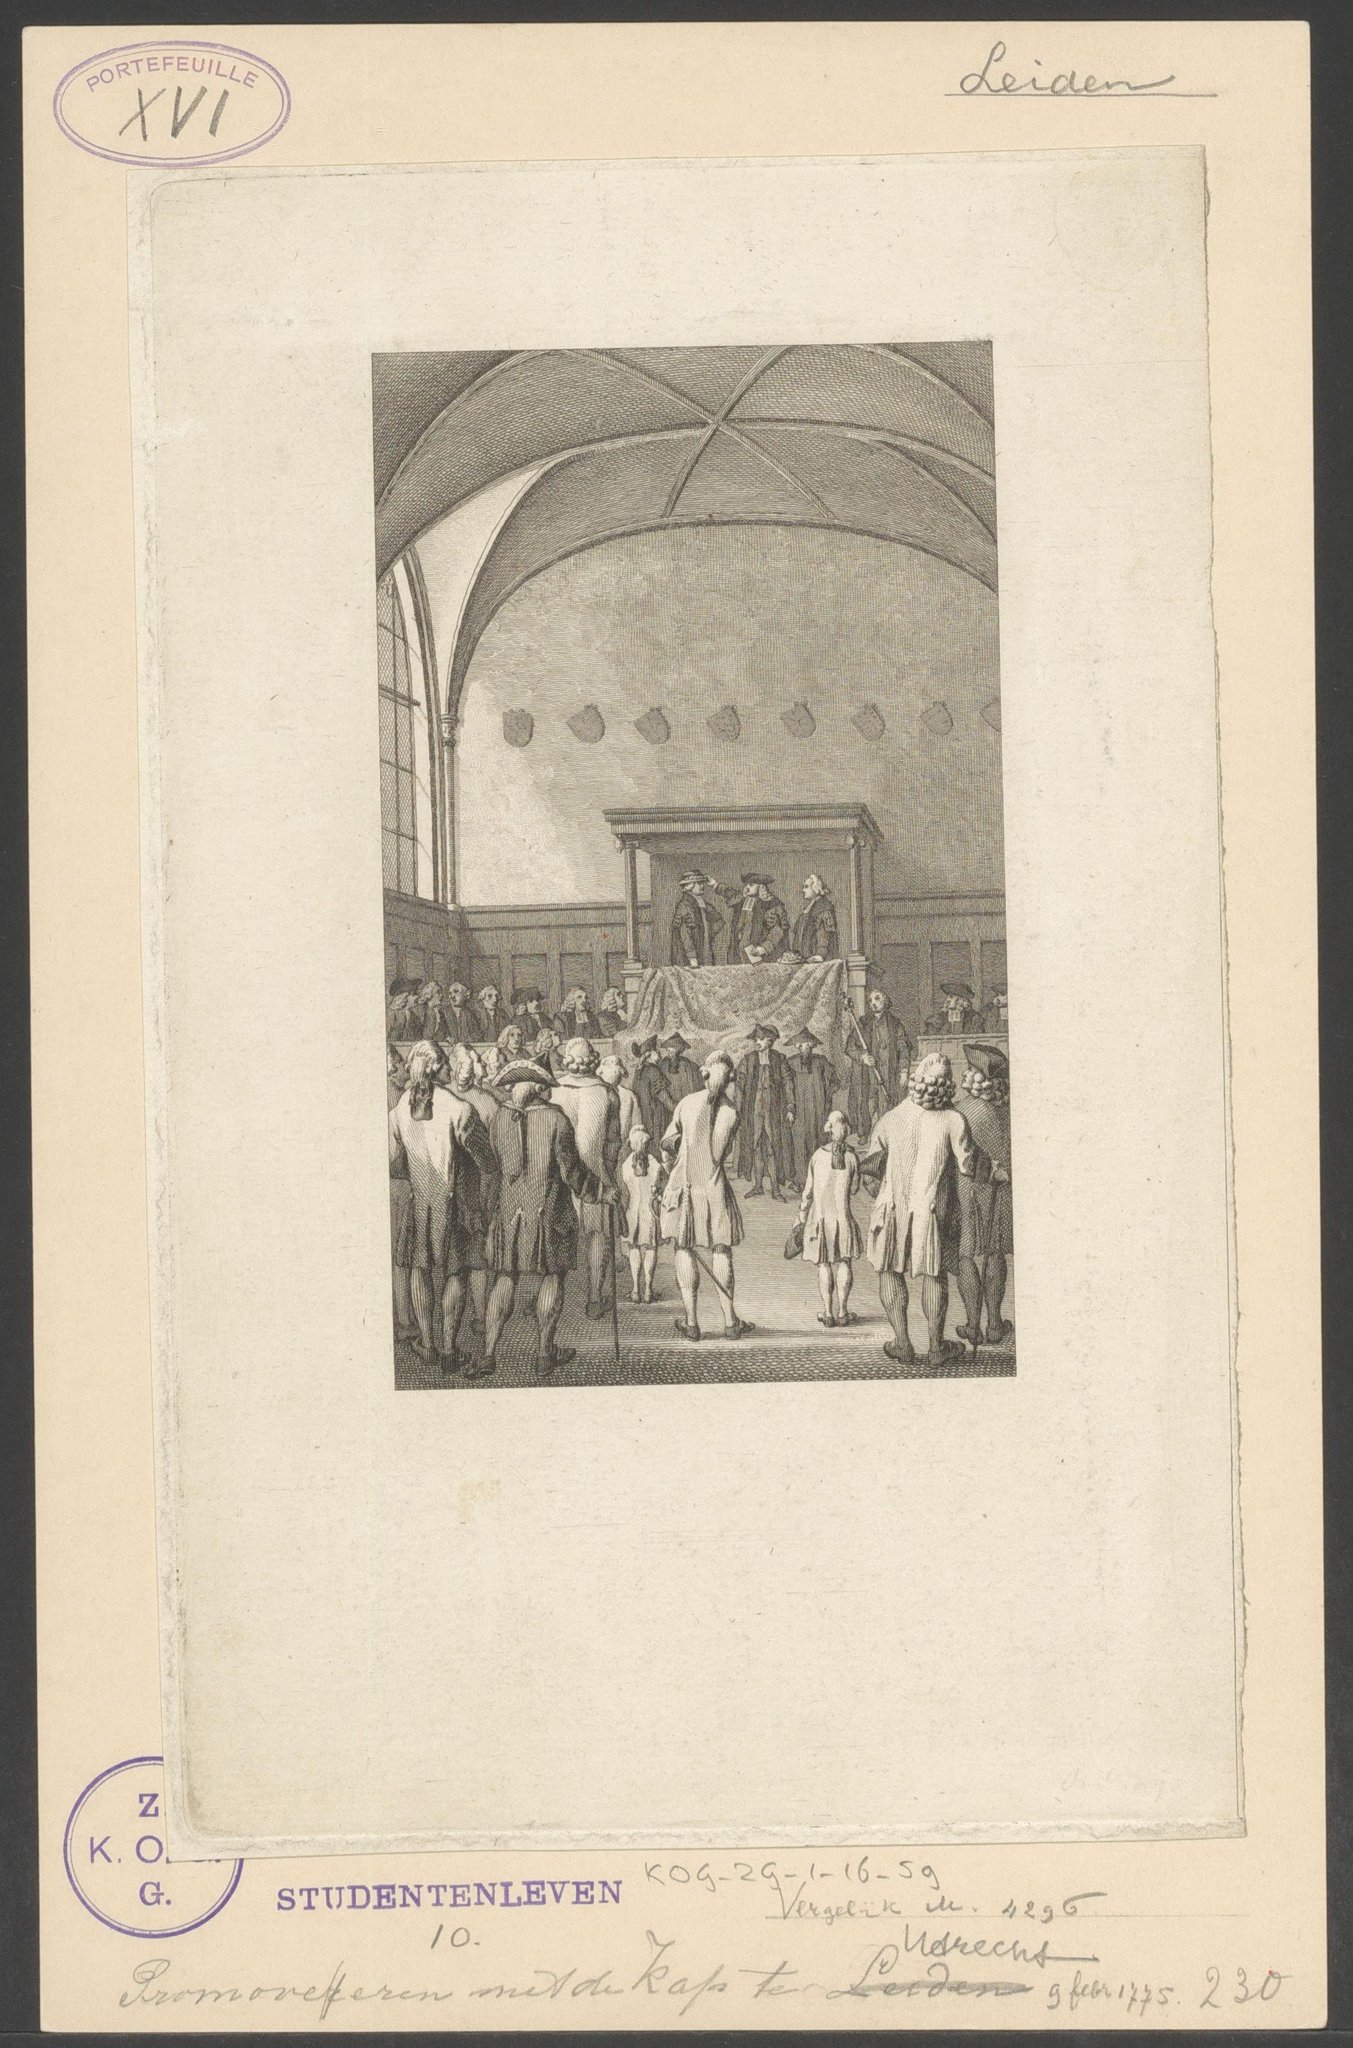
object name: print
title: Promotie met de kap, bij gelegenheid van het Tweede Eeuwfeest van de Leidse Hogeschool, 1775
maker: reinier vinkeles (i)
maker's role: draughtsman, print maker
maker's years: 1741-1816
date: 1775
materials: paper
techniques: engraving, etching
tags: receiving doctor's degree, commemoration of the founding of a university, utrecht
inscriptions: stamp, collector's mark: Lugt 1641, stamp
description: Promotie met de kap in een universiteitszaal bij gelegenheid van het Tweede Eeuwfeest van de oprichting van de Universiteit van Leiden, 9 februari 1775. Onderwerpsrubrieken binnen de Atlas Zeden en Gewoonten: Onderwijs en Wetenschappen, Studentenleven.